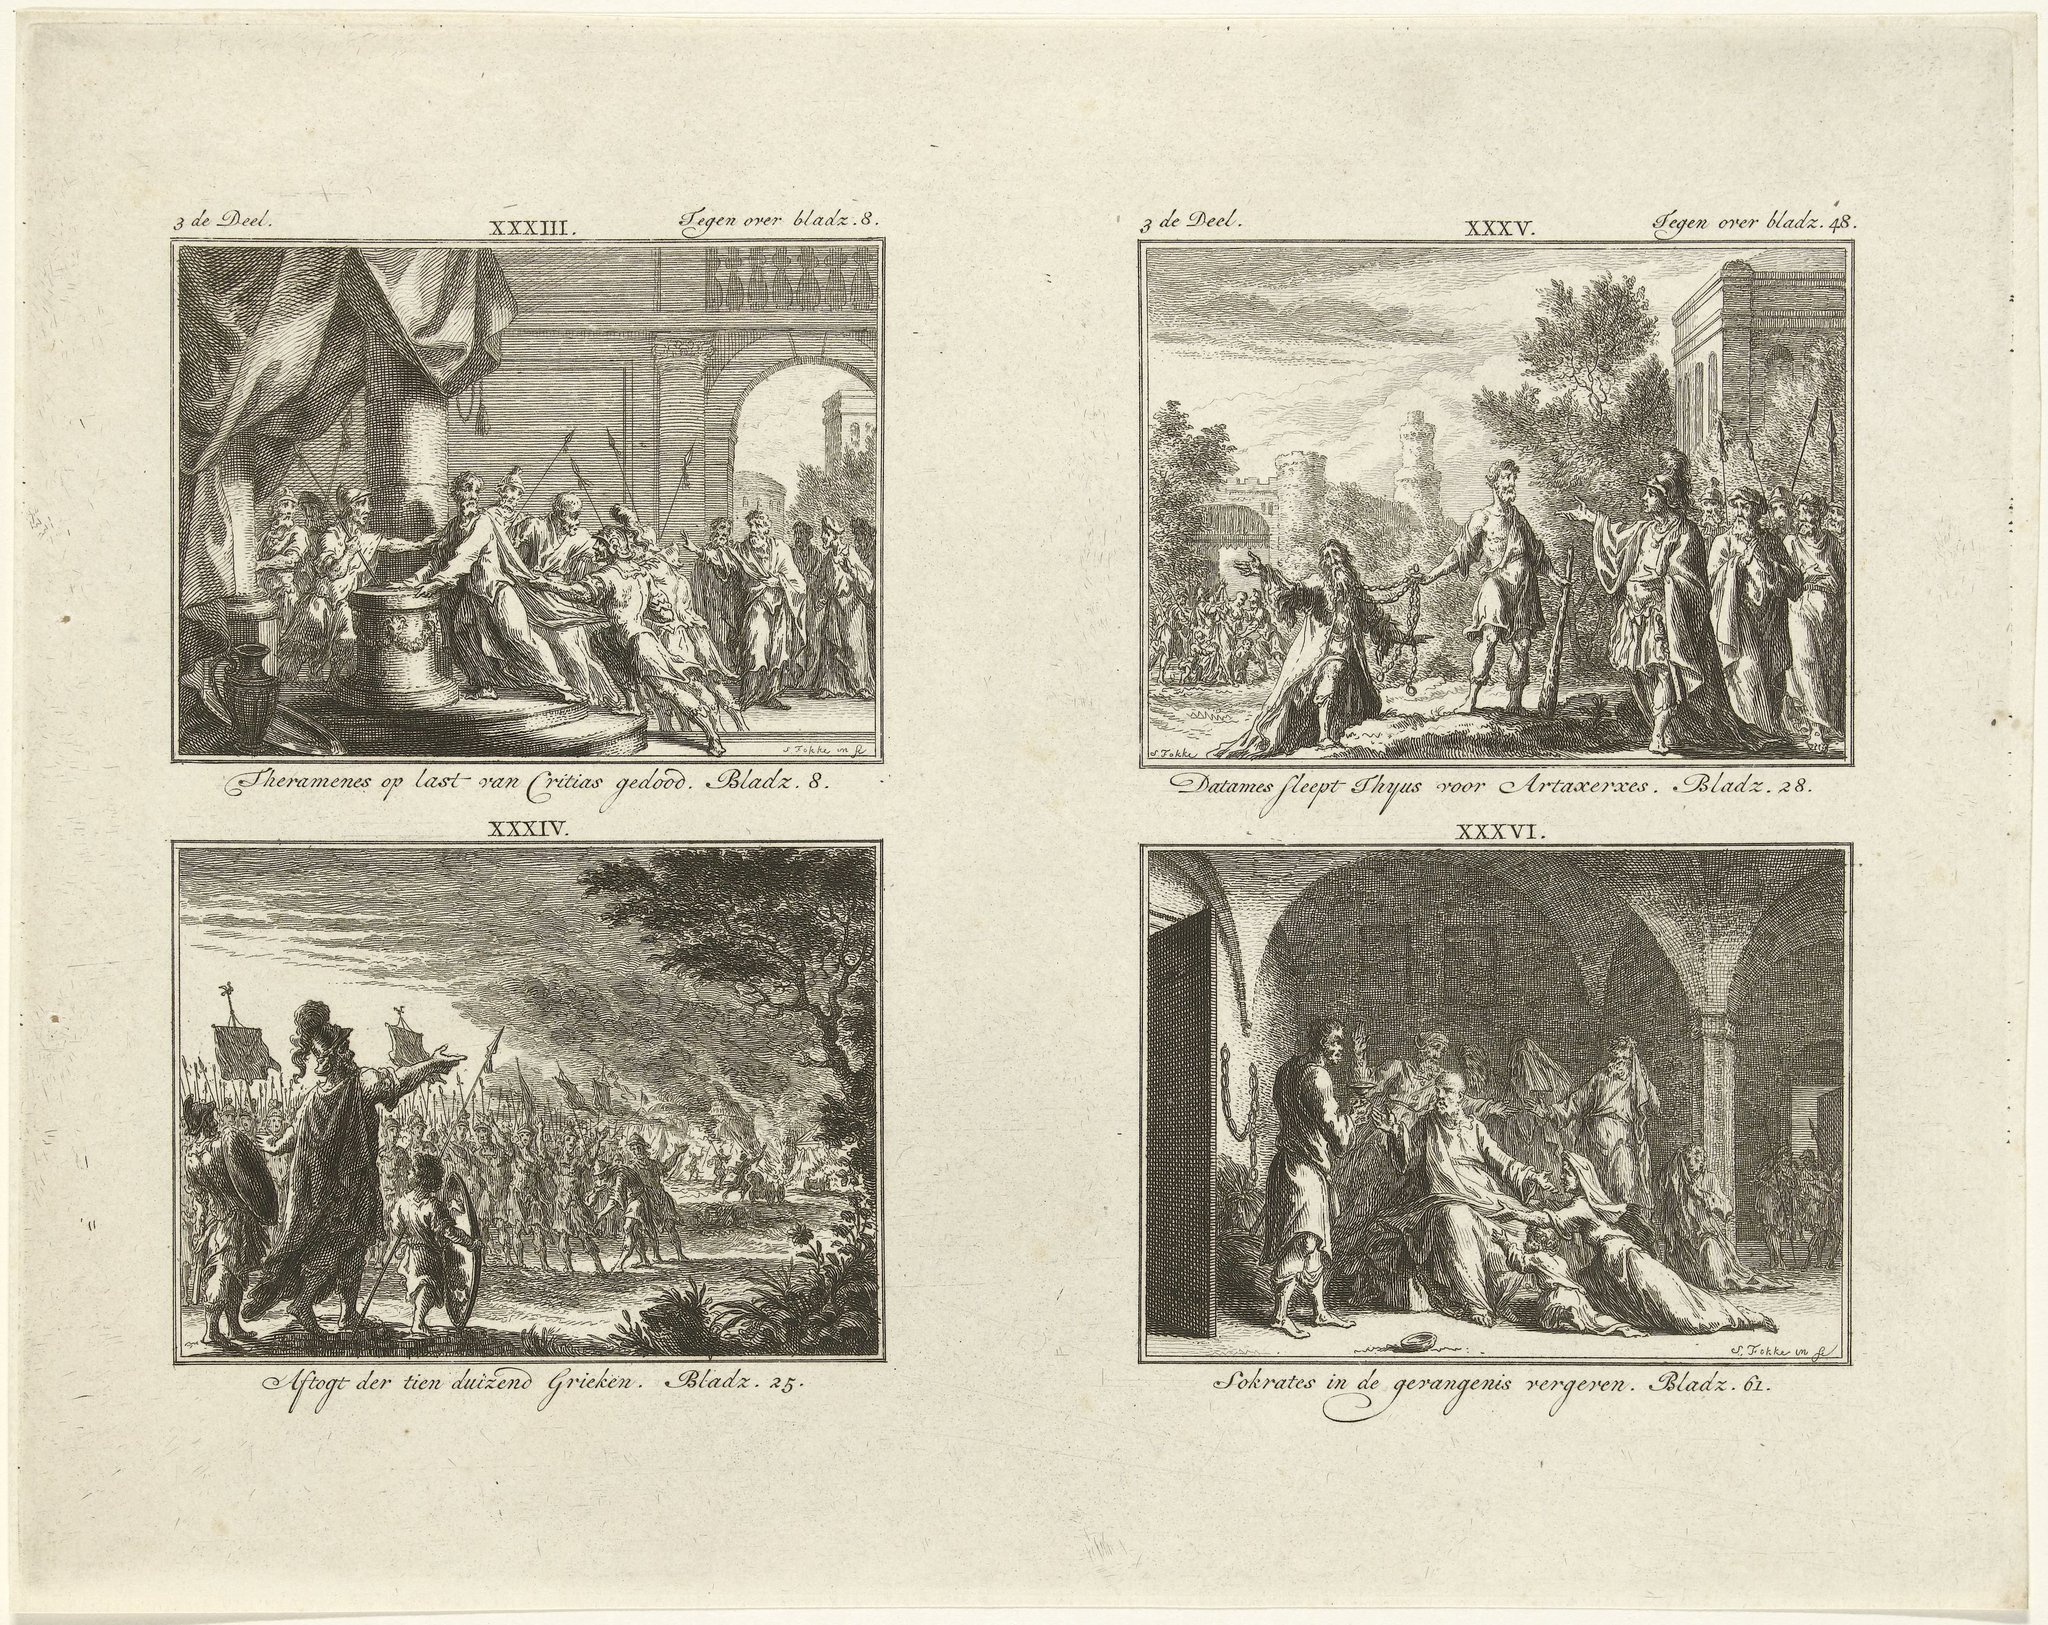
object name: print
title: Vier voorstellingen uit de klassieke geschiedenis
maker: simon fokke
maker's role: draughtsman, print maker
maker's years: 1712-1784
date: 1722-1784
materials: paper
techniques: etching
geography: amsterdam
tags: death of socrates: in prison, surrounded by his grieving disciples, he calmly drinks the cup of poison after having made a libation to the gods, male persons from classical history (datames), (story of) theramenes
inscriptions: collector's mark: Lugt 2228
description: Vier voorstellingen uit de klassieke geschiedenis van één plaat, genummerd van XXXIII tot en met XXXVI en alle voorzien van een onderschrift. Linksboven: Theramenes op last van Critias gedood. Linksonder: Terugtocht van tienduizend Grieken. Rechtsboven: Datames sleept Thyus voor Artaxerxes. Rechtsonder: Socrates wordt in de gevangenis vergeven. Voorstellingen XXXIII en XXXIV rechtsboven gemerkt: Tegen over bladz. 8. Voorstellingen XXXV en XXXVI rechtsboven gemerkt: Tegen over bladz. 48.